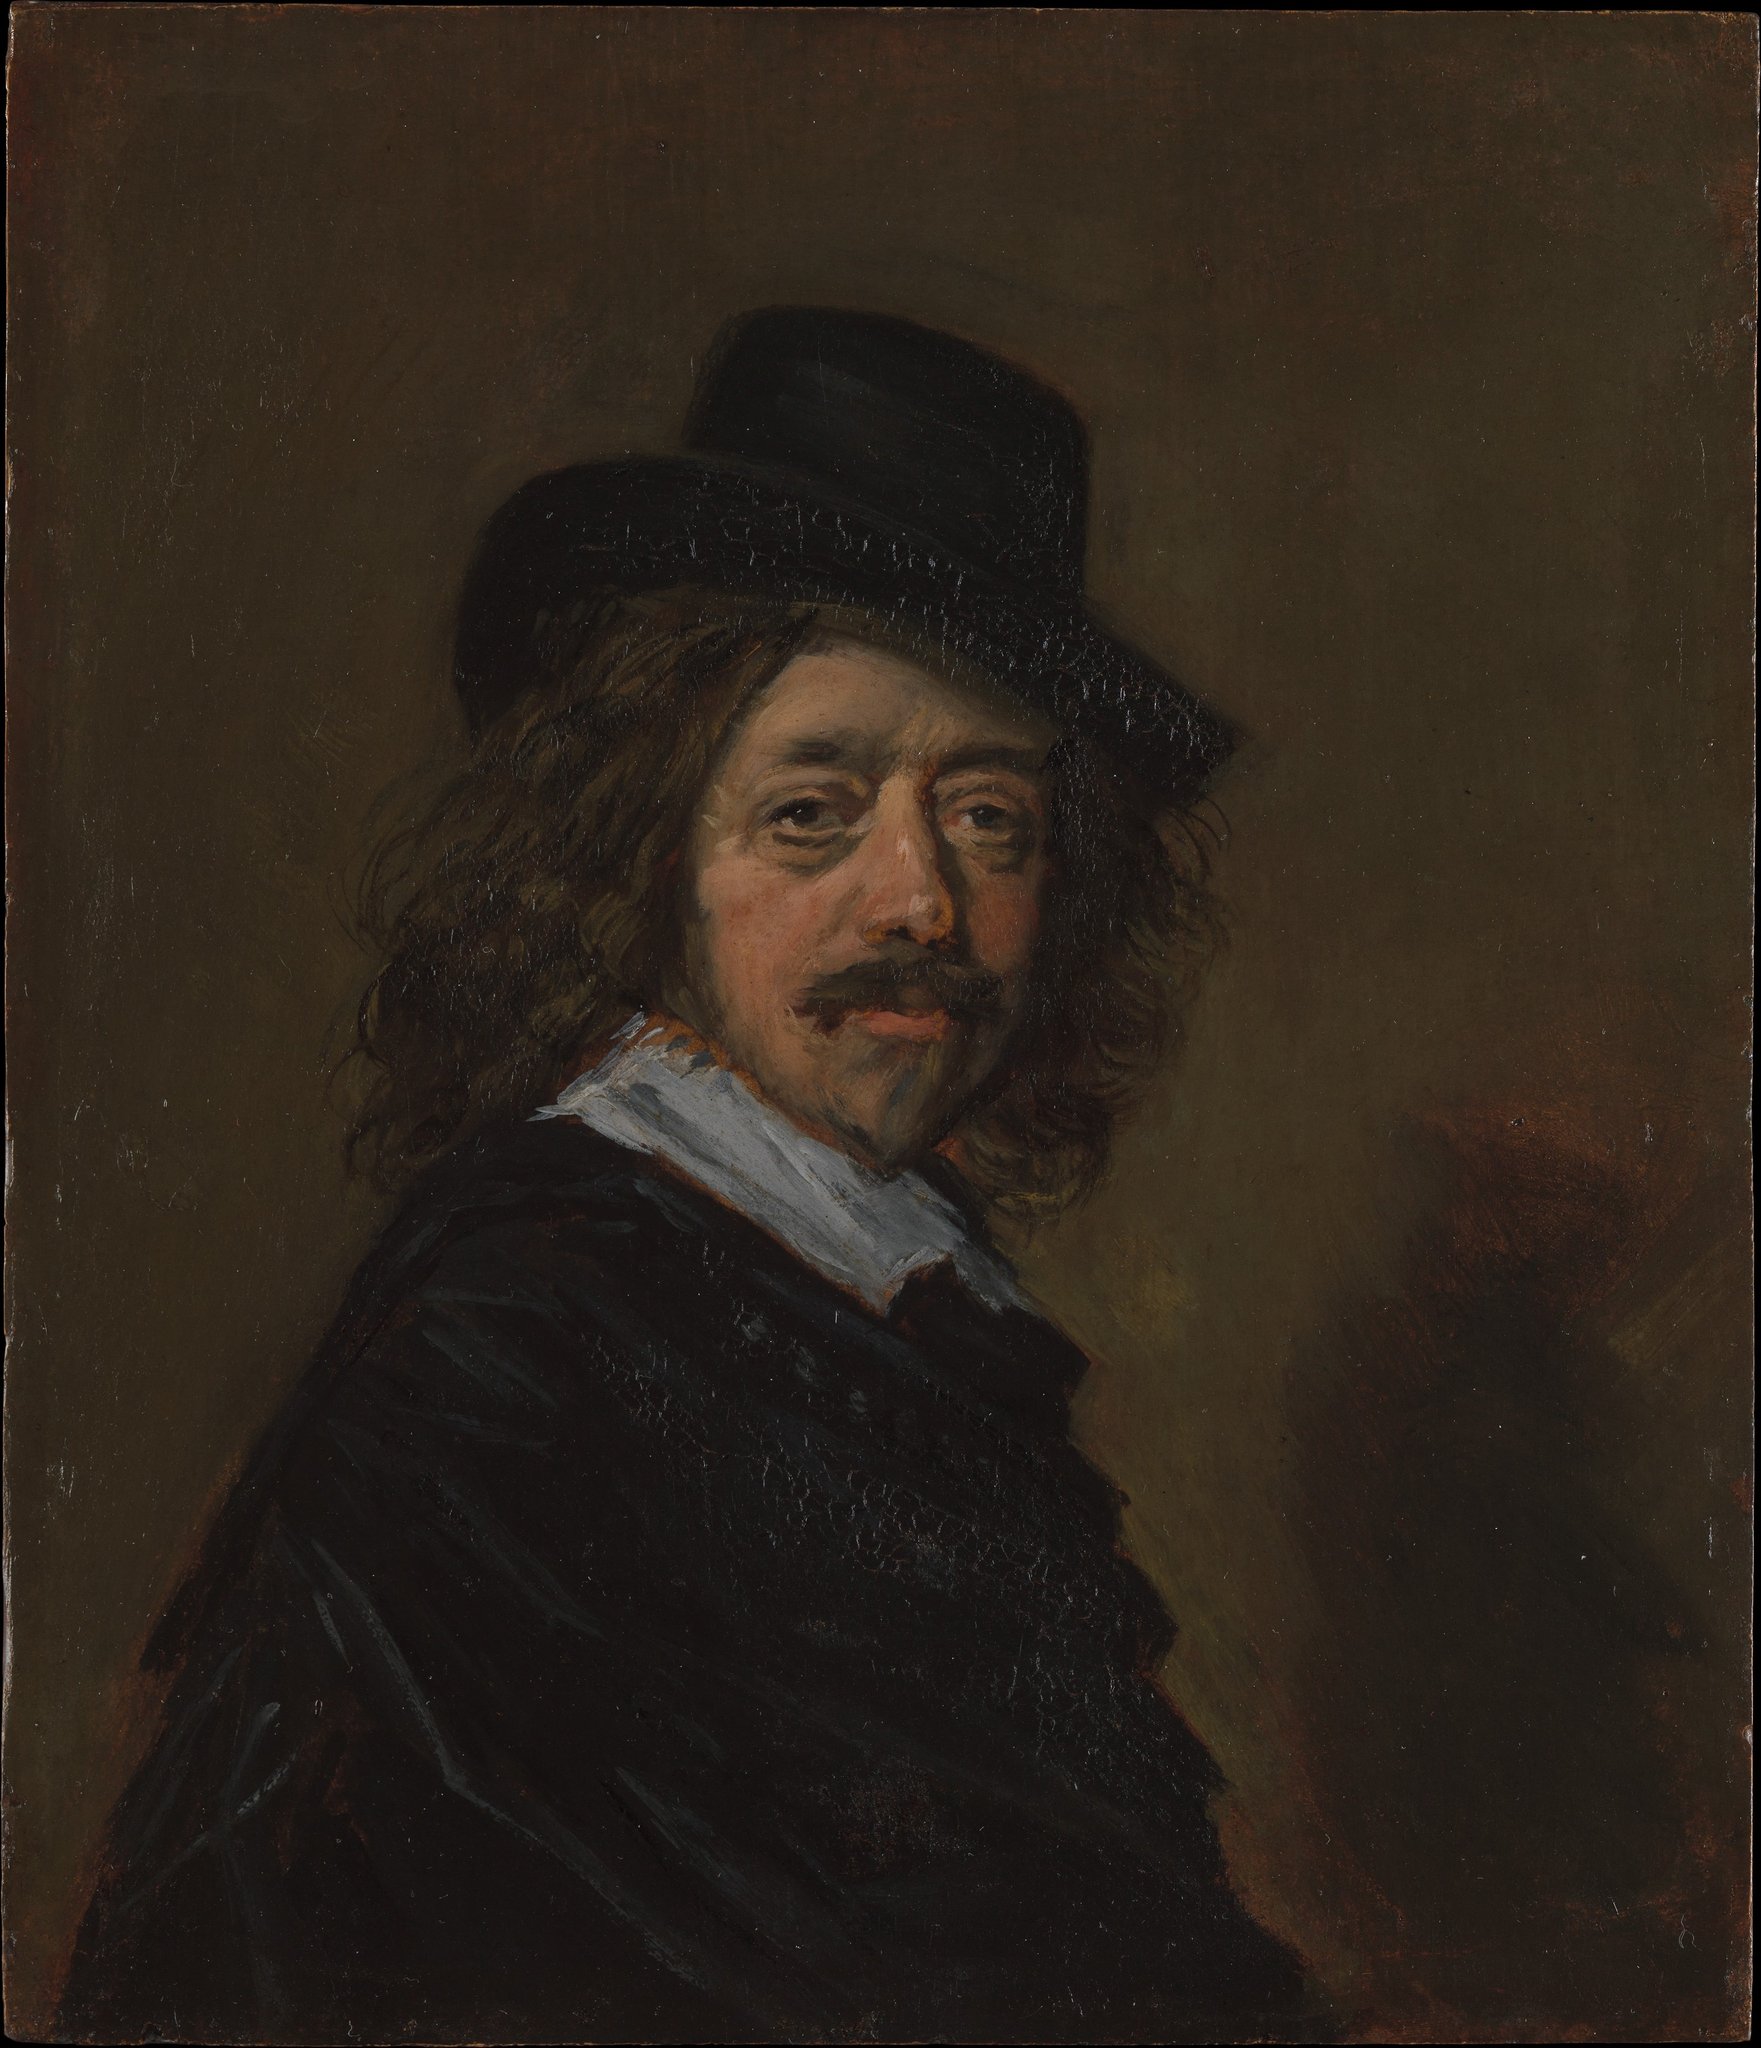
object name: painting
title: Frans Hals (1582/83–1666)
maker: frans hals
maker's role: artist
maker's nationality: dutch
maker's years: 1582-1666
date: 1650-1659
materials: oil, wood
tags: men,portraits,artists